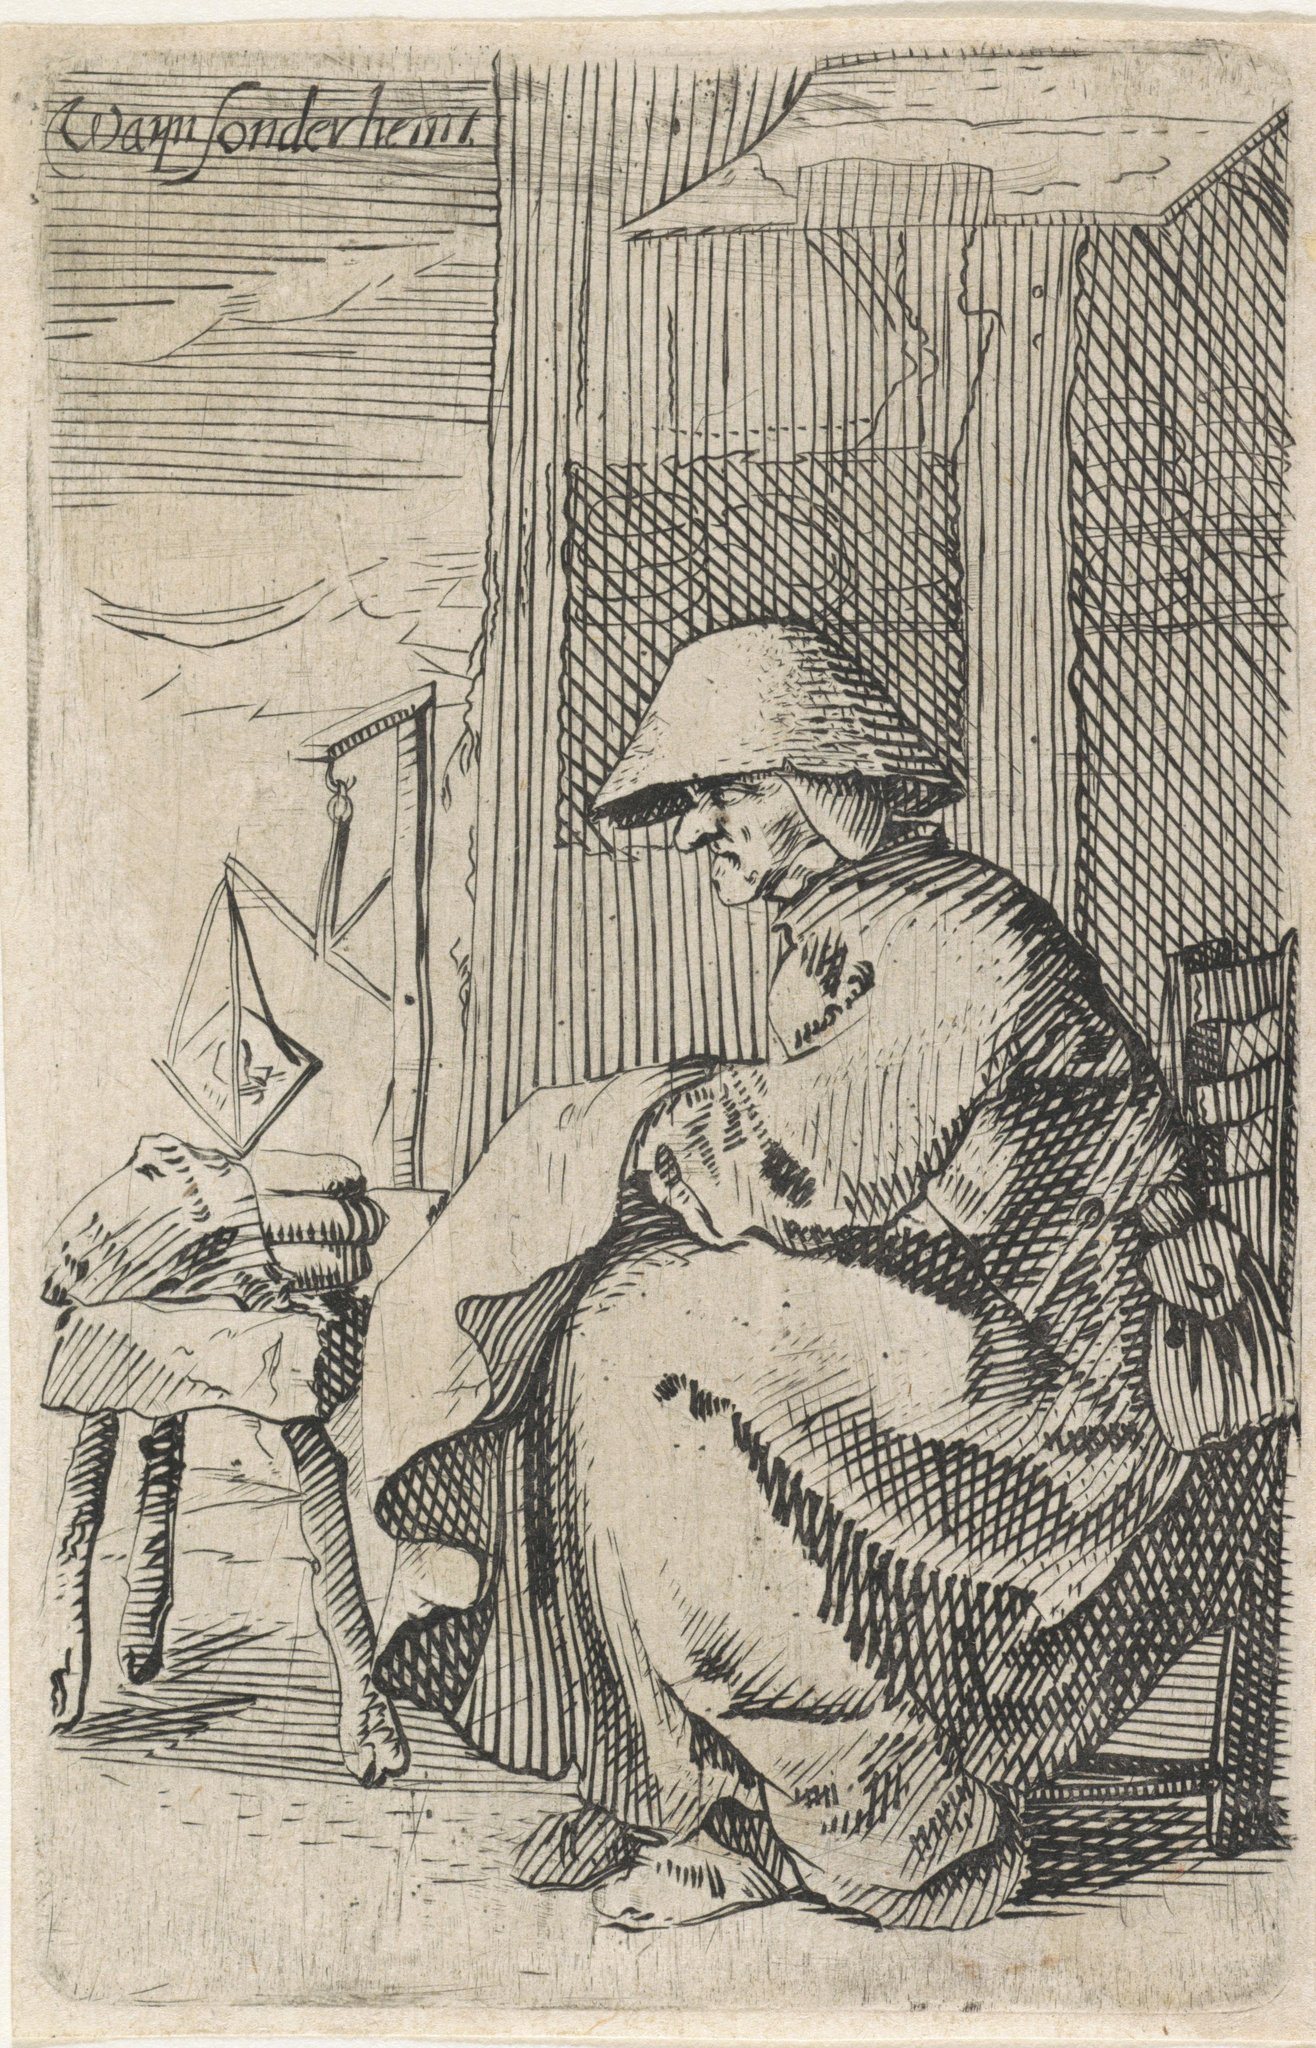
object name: print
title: T leven der boer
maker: reinhard voskens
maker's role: print maker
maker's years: 1623-1685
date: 1633-1665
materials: paper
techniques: engraving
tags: scales, farmers, textile fabric, cloth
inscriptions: collector's mark: Lugt 240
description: Een vrouw met een stuk stof in haar handen. Voor haar een tafel waarop een stapel lappen en een weegschaal. Bovenaan: Way sonder hemt.